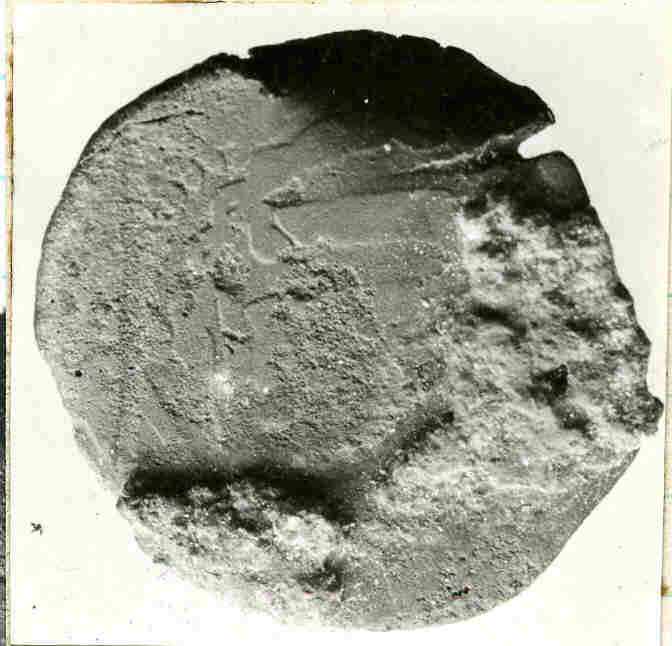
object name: coin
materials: copper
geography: iran